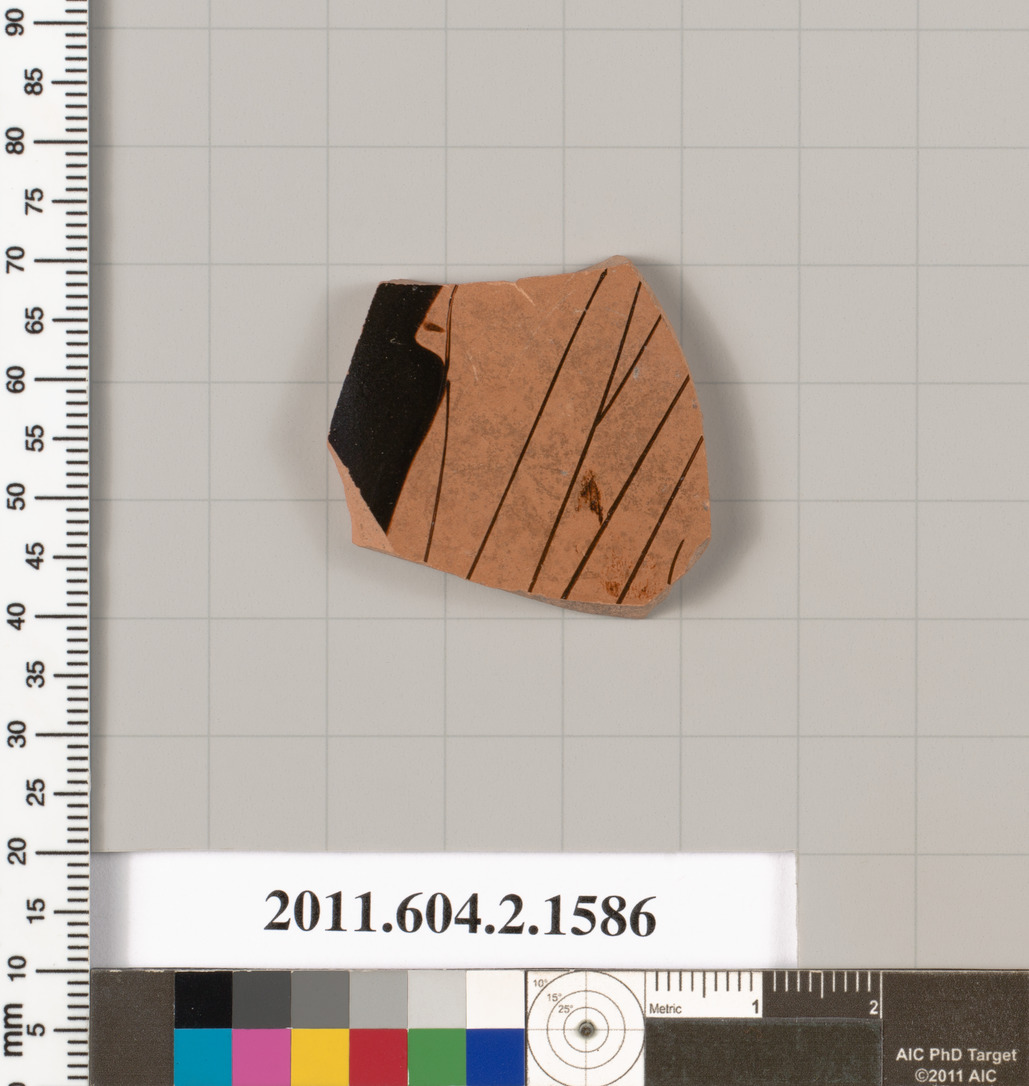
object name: skyphos fragment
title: Terracotta fragment of a skyphos (deep drinking cup)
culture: greek, attic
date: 460-440 BCE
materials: terracotta